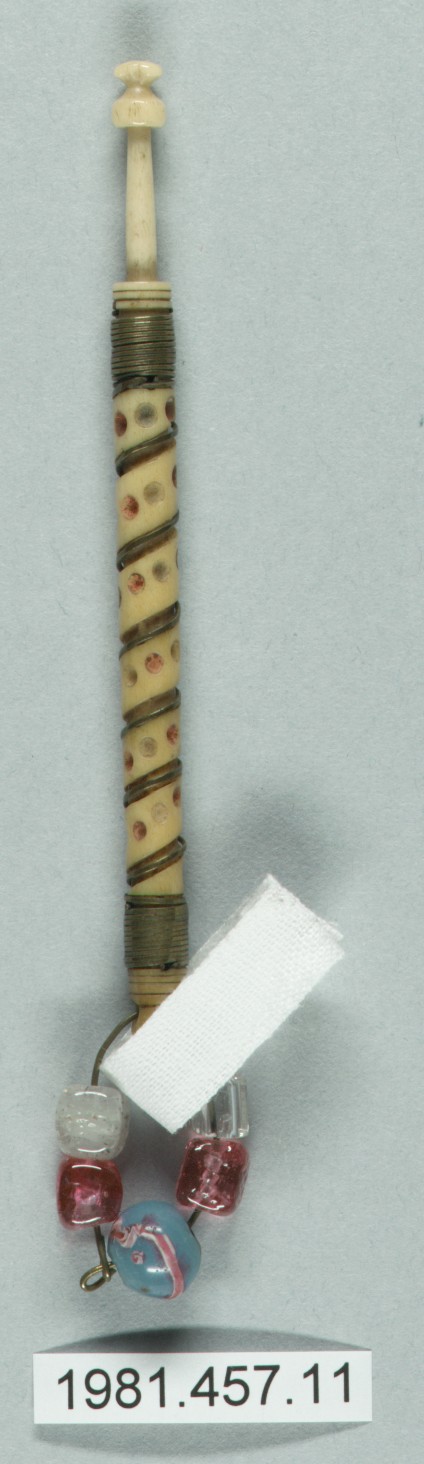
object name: bobbin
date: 1840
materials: wood